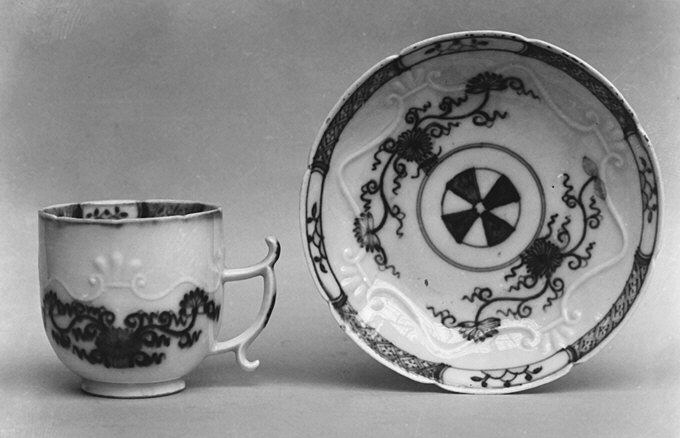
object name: cup and saucer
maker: meissen manufactory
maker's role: manufactory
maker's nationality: german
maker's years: 1710-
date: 1740-1745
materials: hard paste porcelain